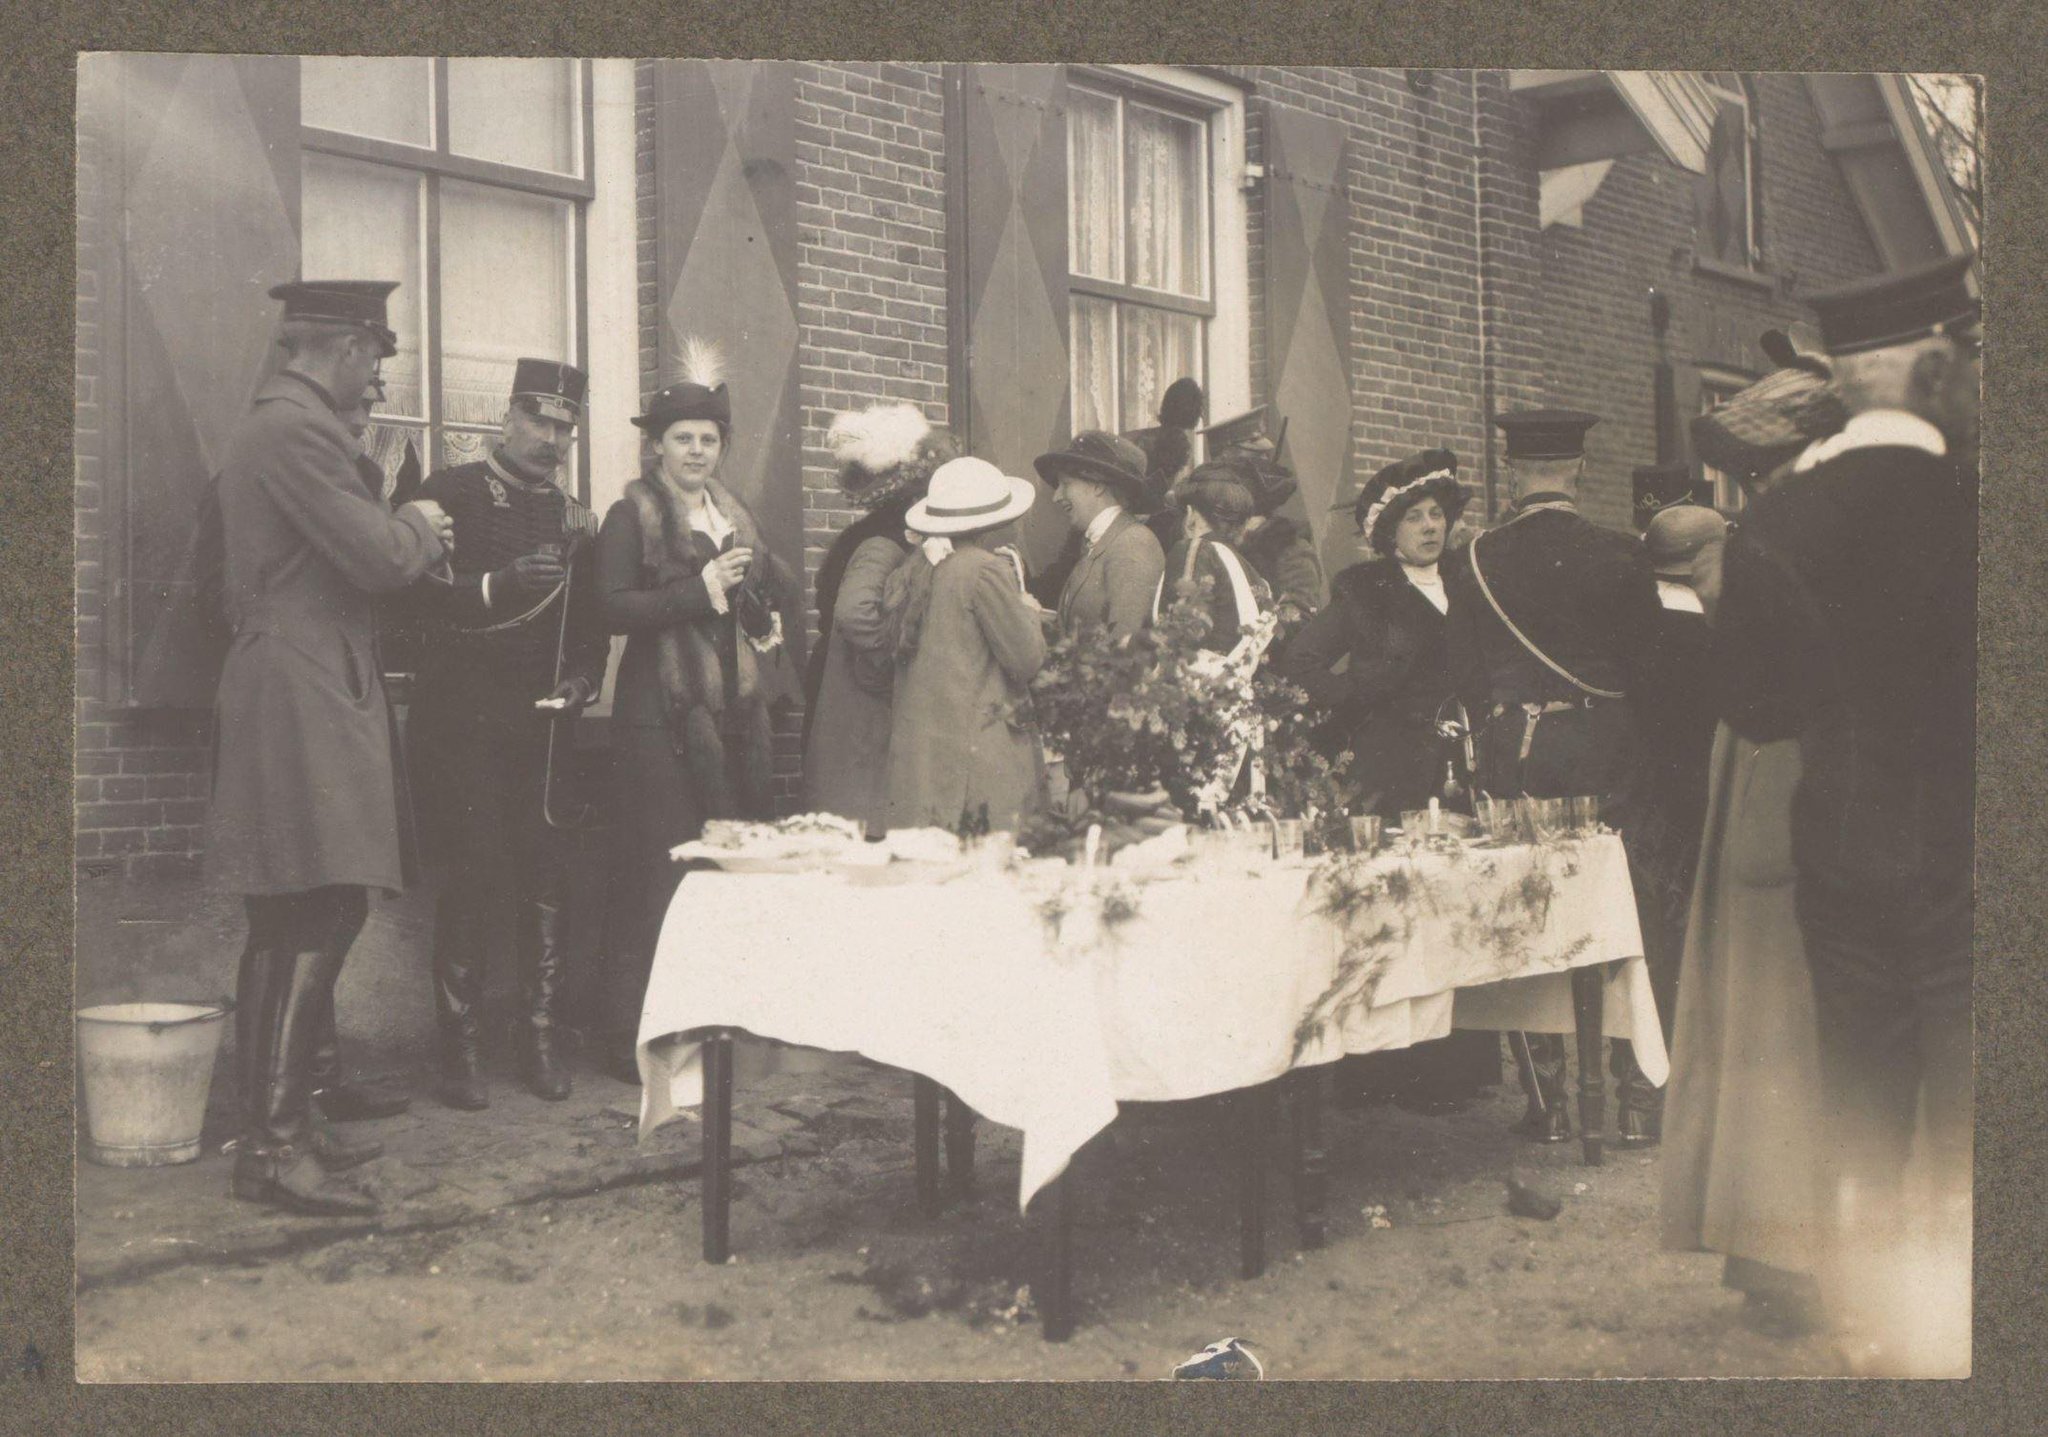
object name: photograph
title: Ruitertafereel op Koninklijke Houtvesterij Het Loo: gezelschap bij gedekte tafels bij een huis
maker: Anonymous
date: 1900-1925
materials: photographic support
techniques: gelatin silver print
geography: het loo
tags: hunting, chase, hunting-ground, eating and drinking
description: Onderdeel van Fotoalbum van de heer Brams, opperhoutvester van koningin Wilhelmina op Koninklijke Houtvesterij Het Loo.